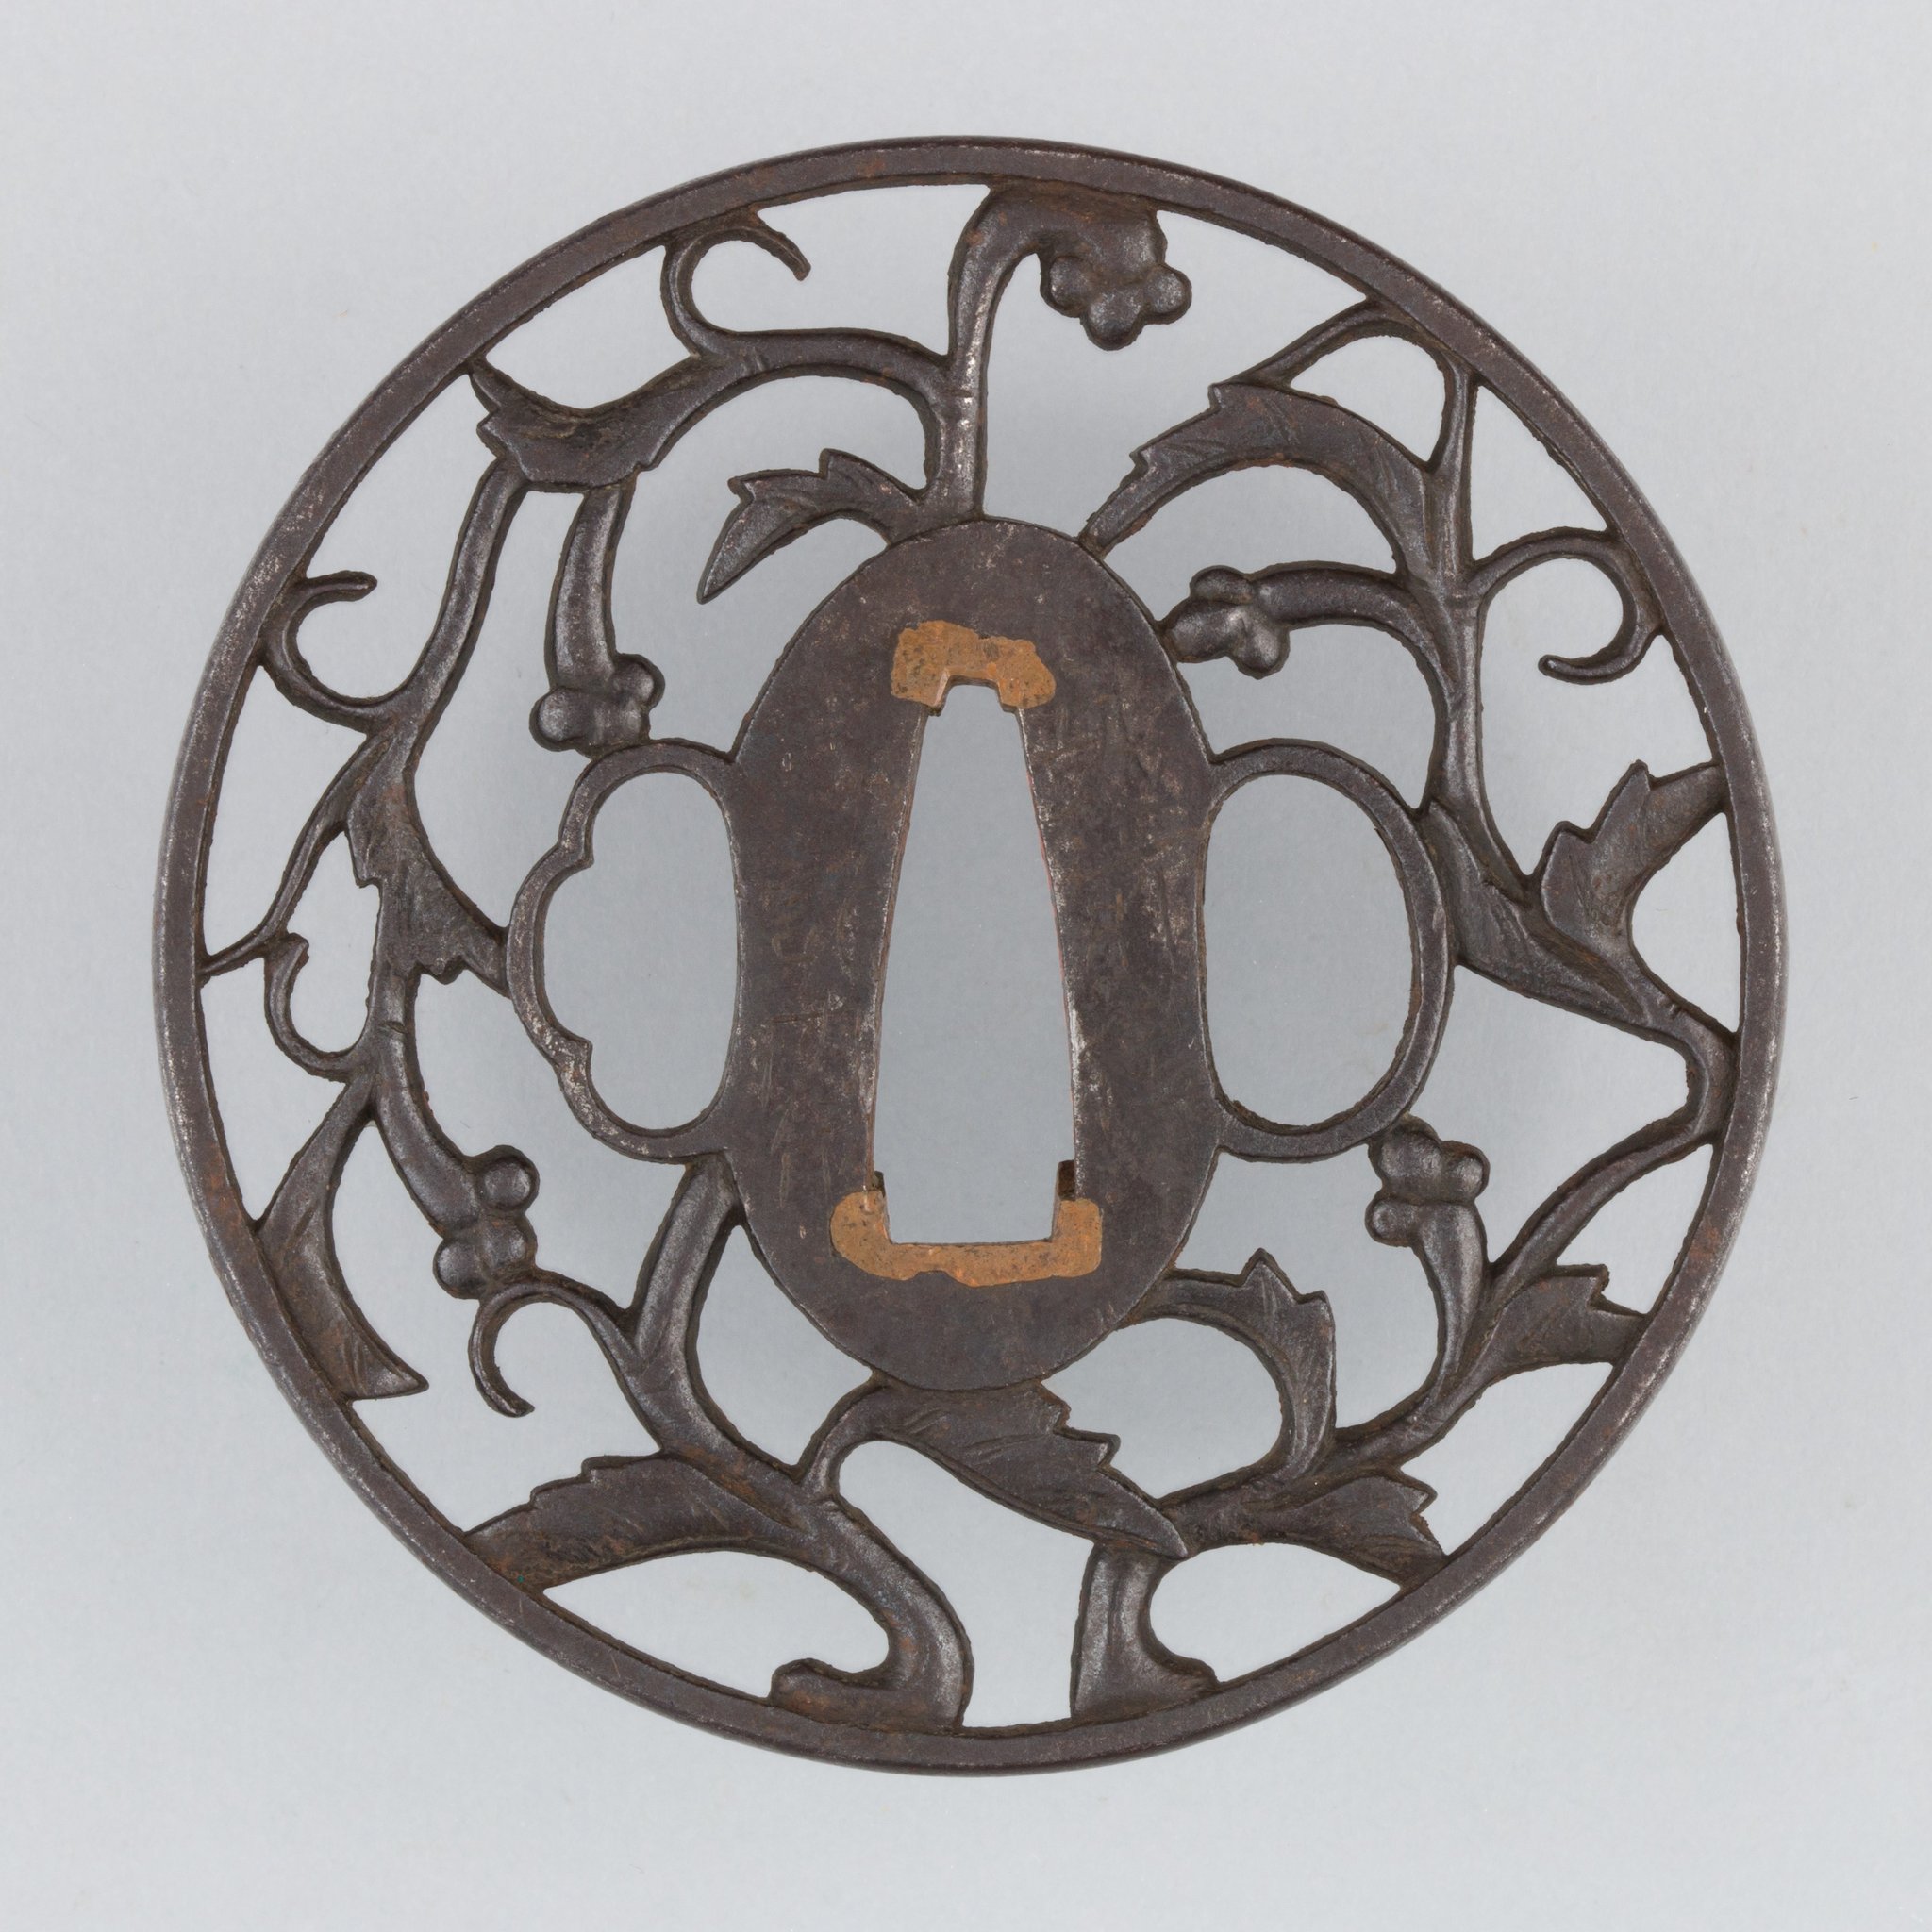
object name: sword guard tsuba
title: Sword Guard (Tsuba)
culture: japanese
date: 1615-1868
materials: copper, iron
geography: japan